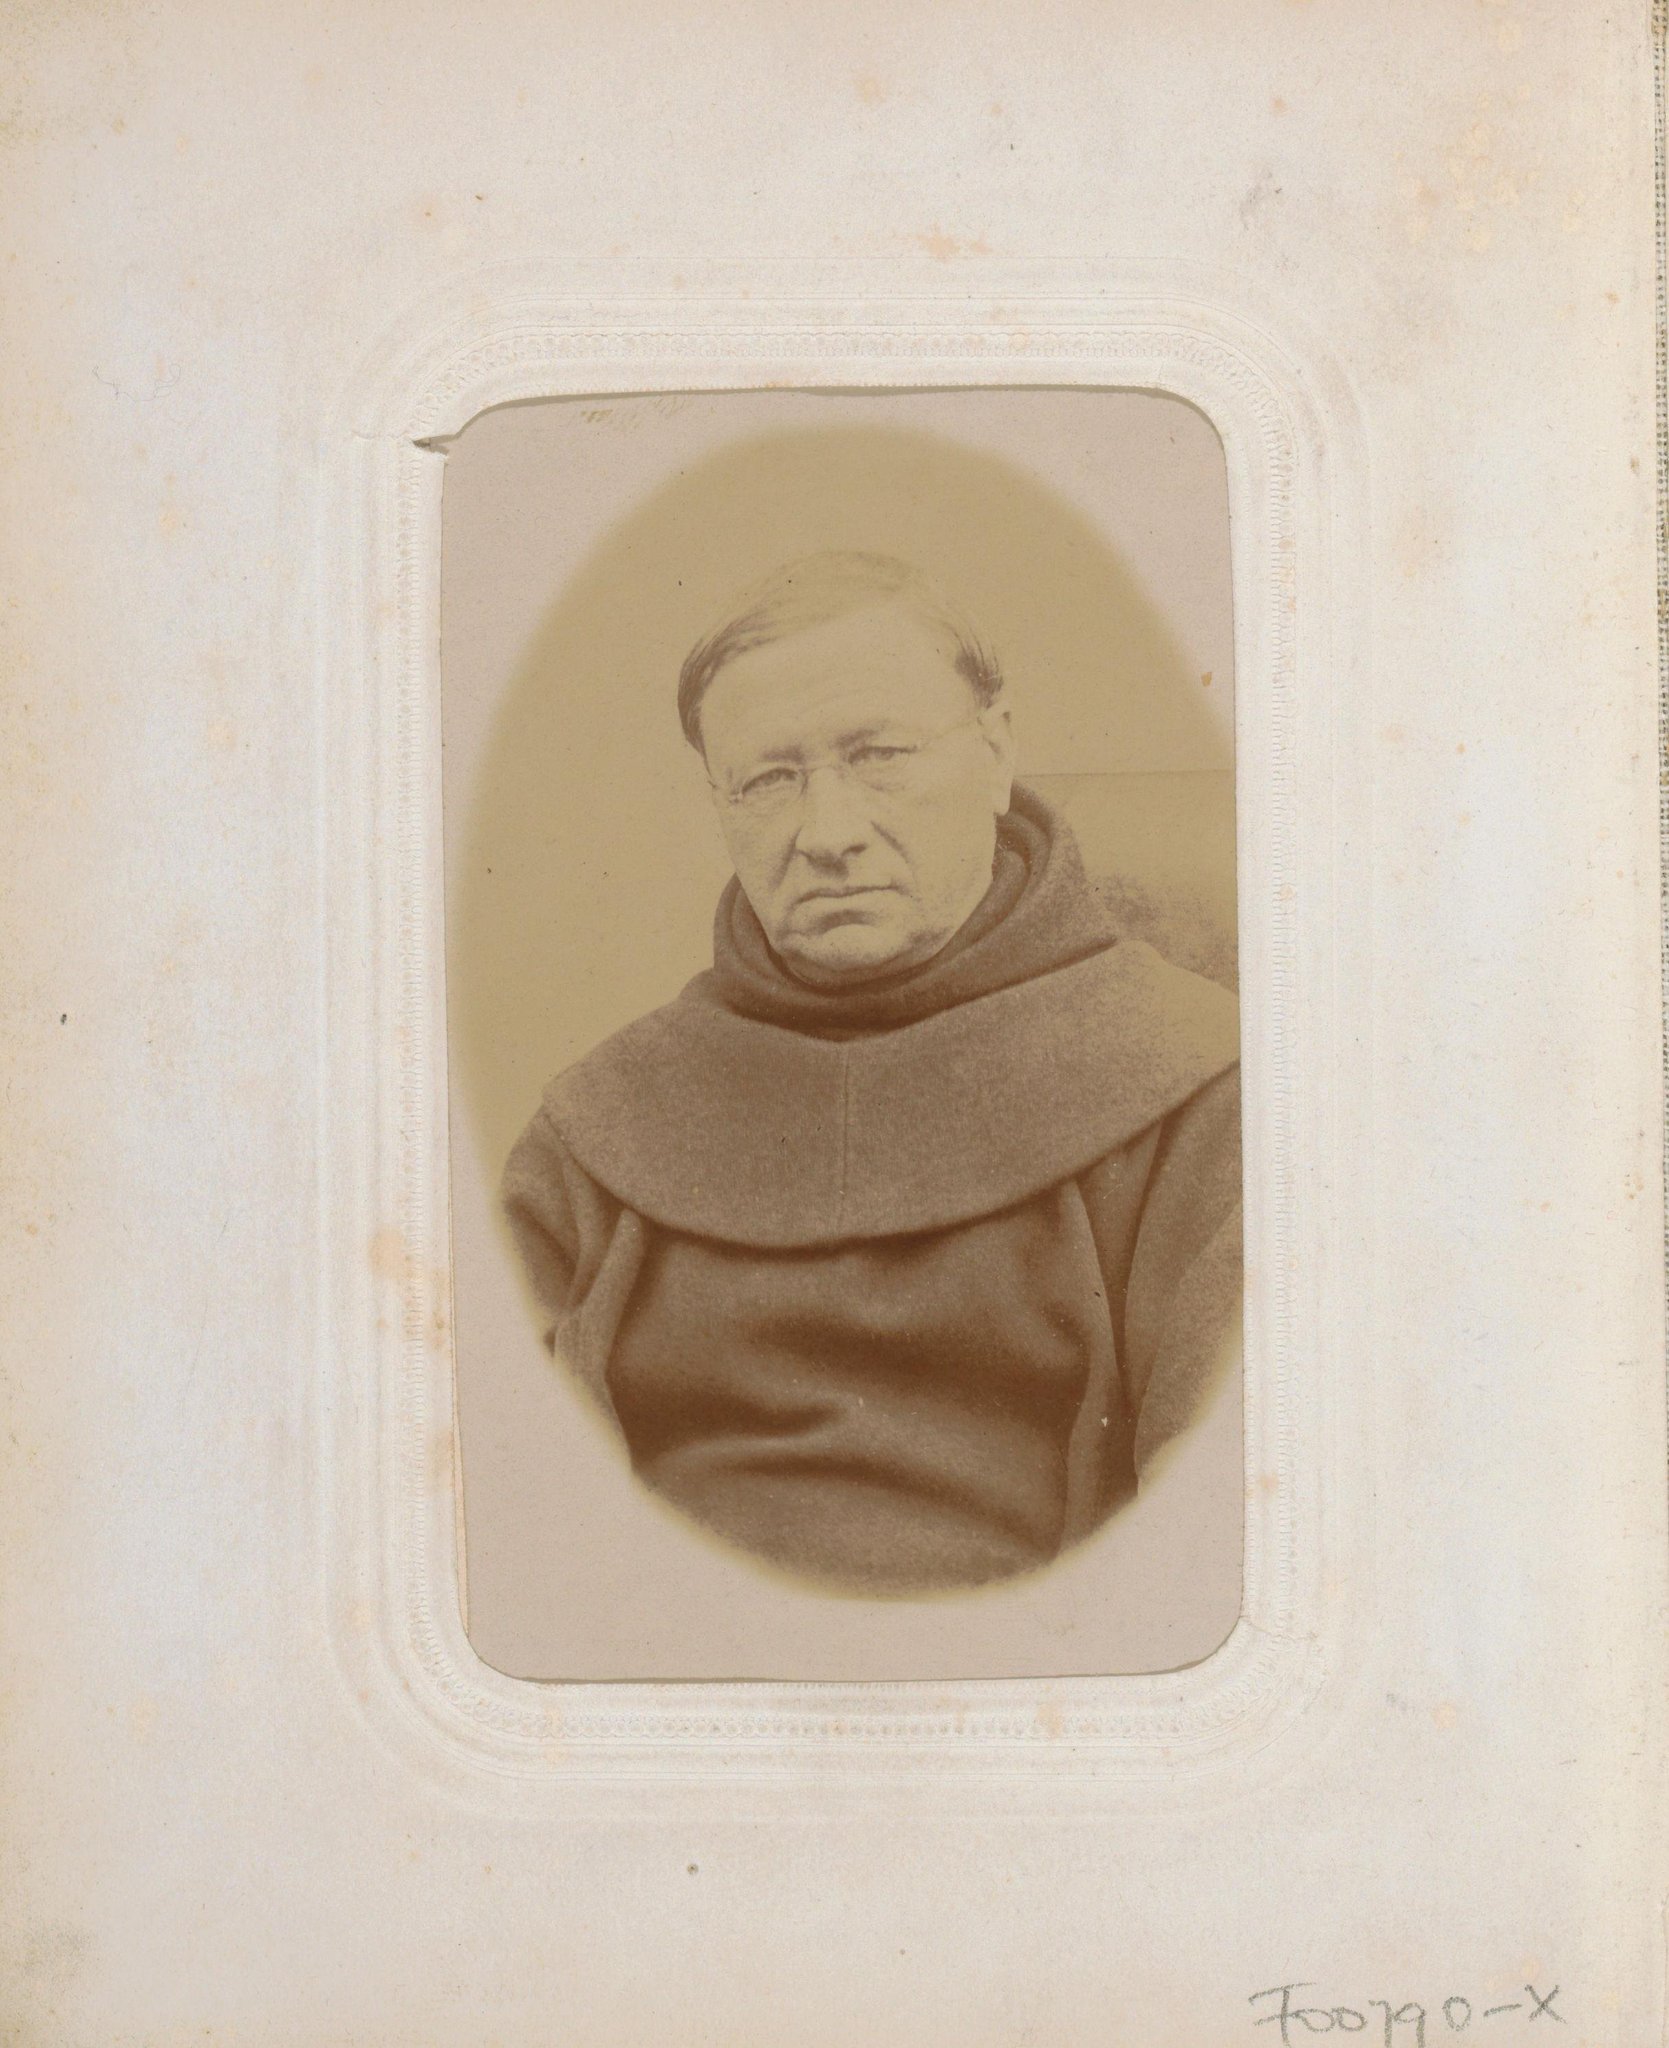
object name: carte de visite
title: Portret van een geestelijke met een bril in een pij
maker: Anonymous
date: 1860-1870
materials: cardboard, paper, photographic support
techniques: albumen print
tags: eyeglasses, spectacles, habit, frock, monk(s), friar(s)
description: Onderdeel van Fotoalbum met 26 cartes-de-visite van rooms-katholieke geestelijken.